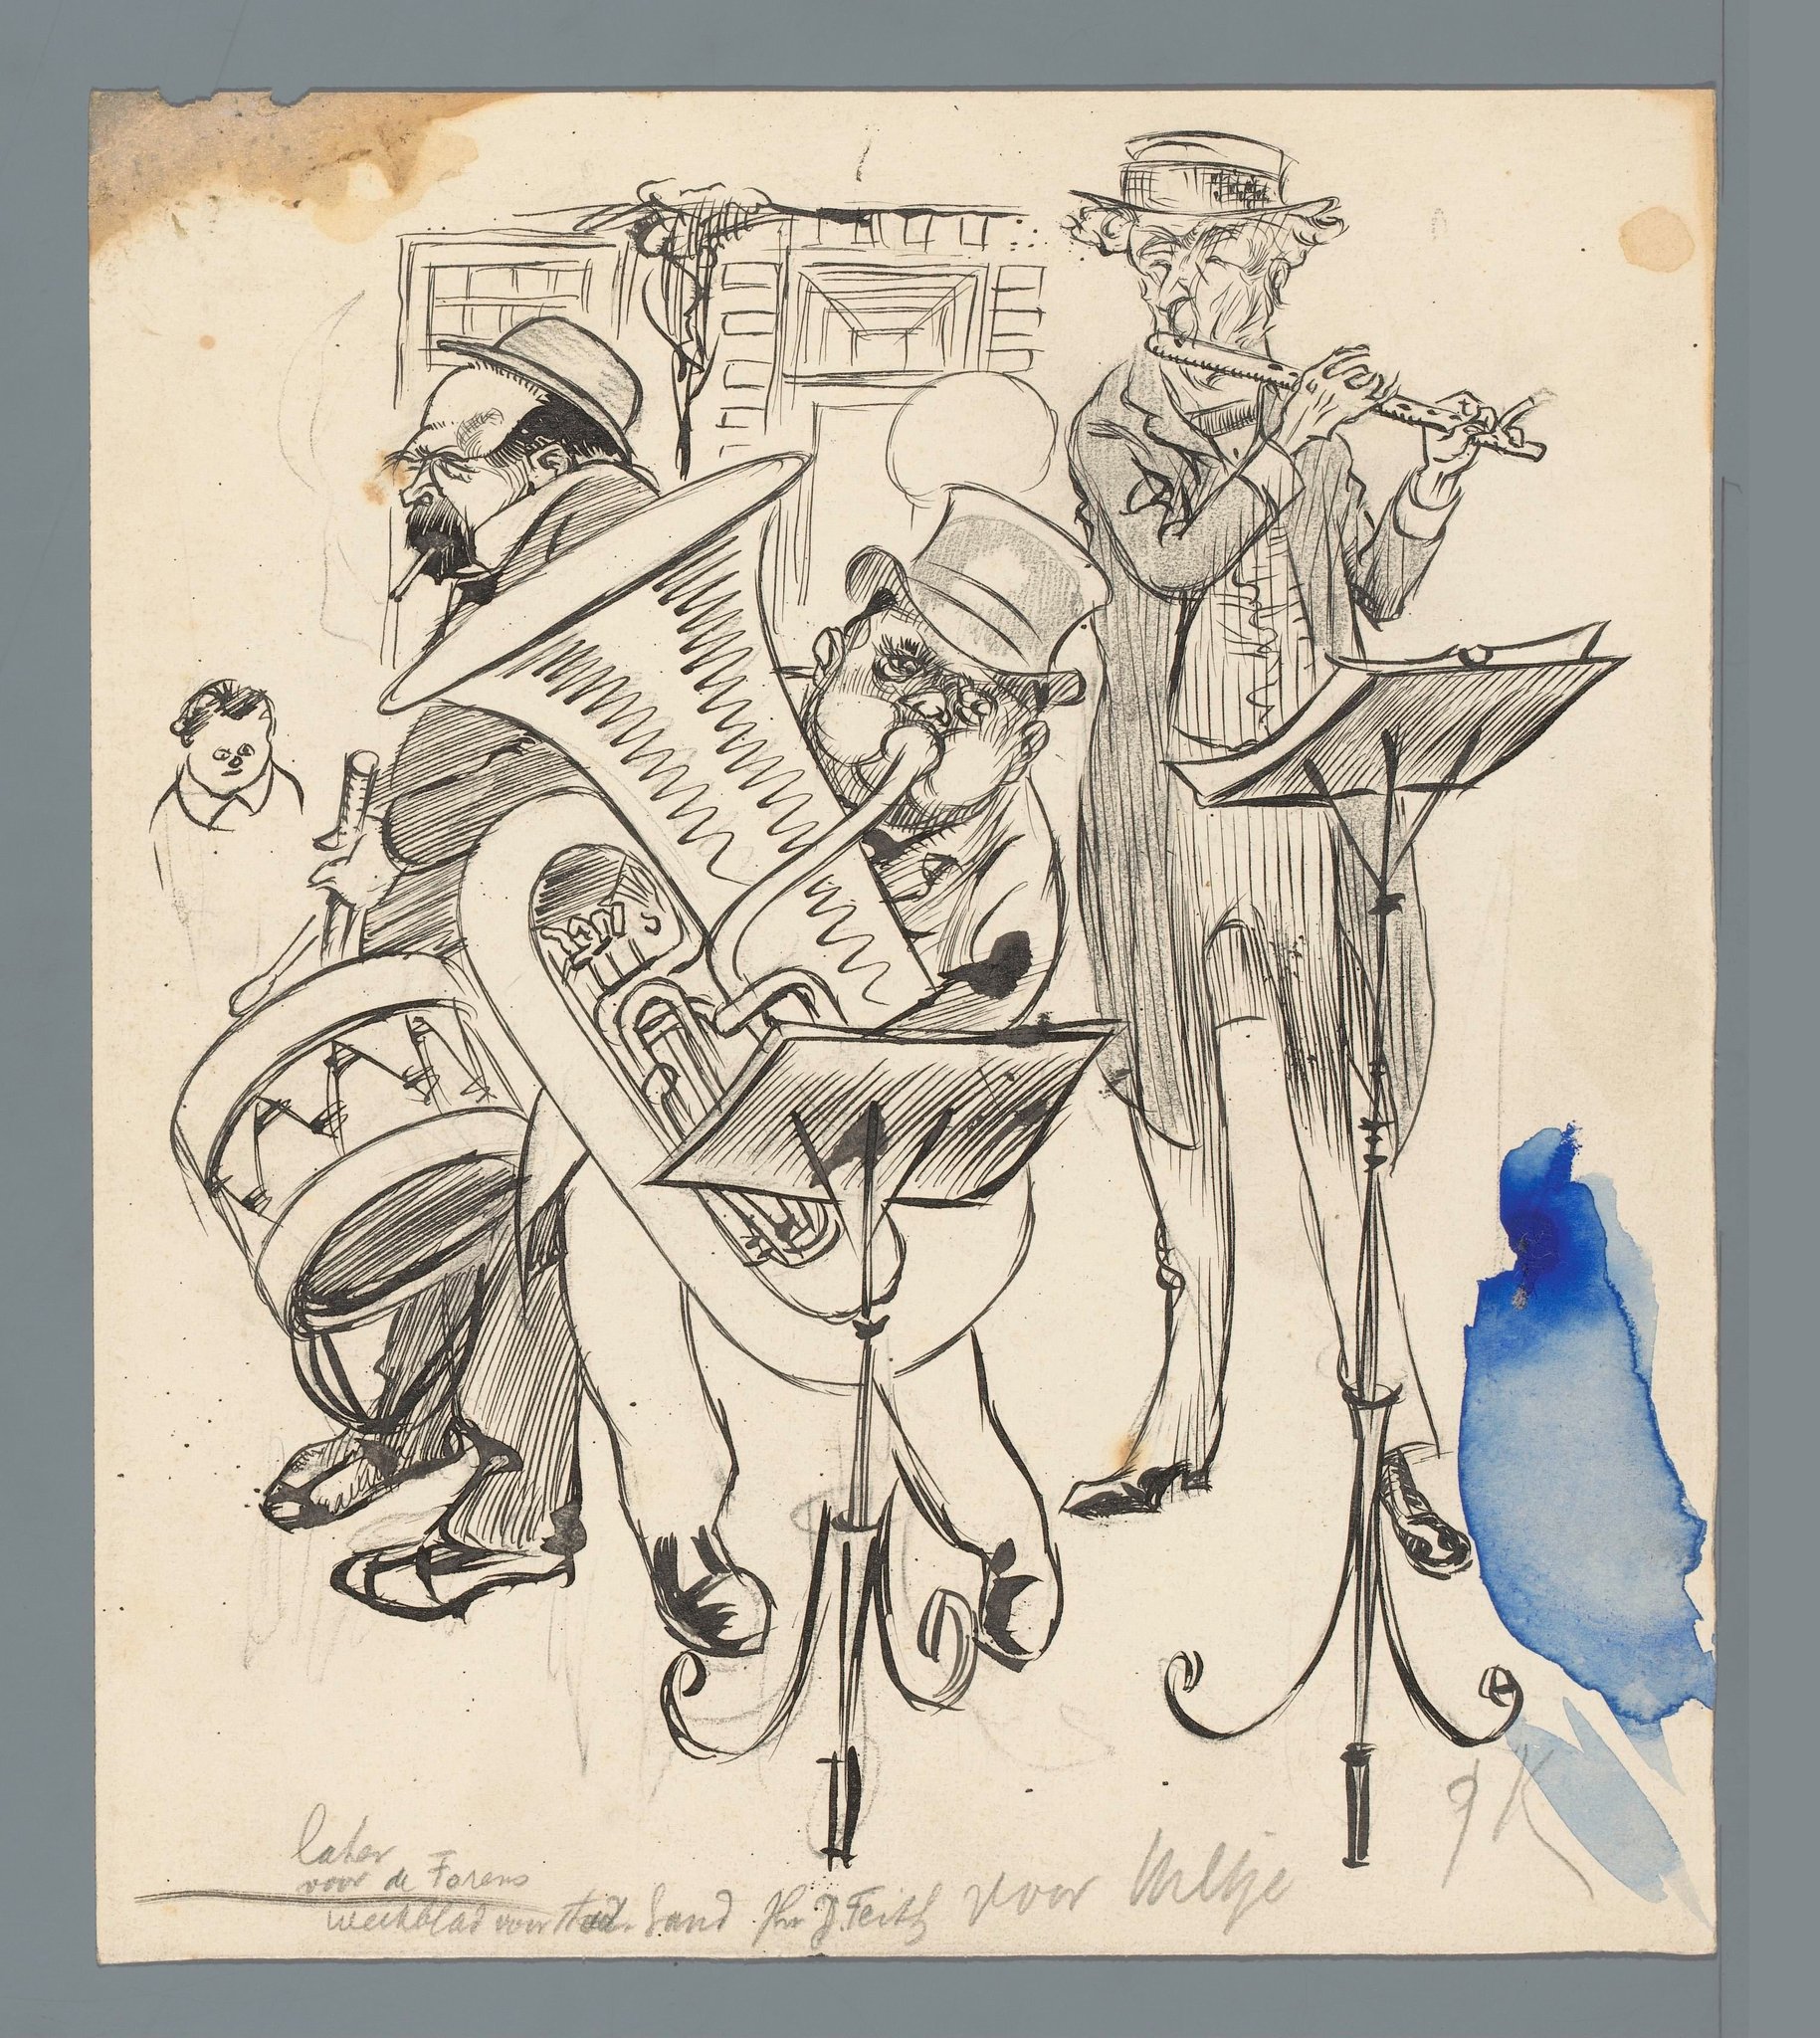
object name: cartoon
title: Drie muzikanten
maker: patricq kroon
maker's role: draughtsman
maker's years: 1862-1941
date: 1920-1930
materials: ink, paper, pencil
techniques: pen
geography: netherlands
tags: popular music, street music, political caricatures and satires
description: Drie muzikanten spelend op straat. Ontwerp voor een politieke spotprent.